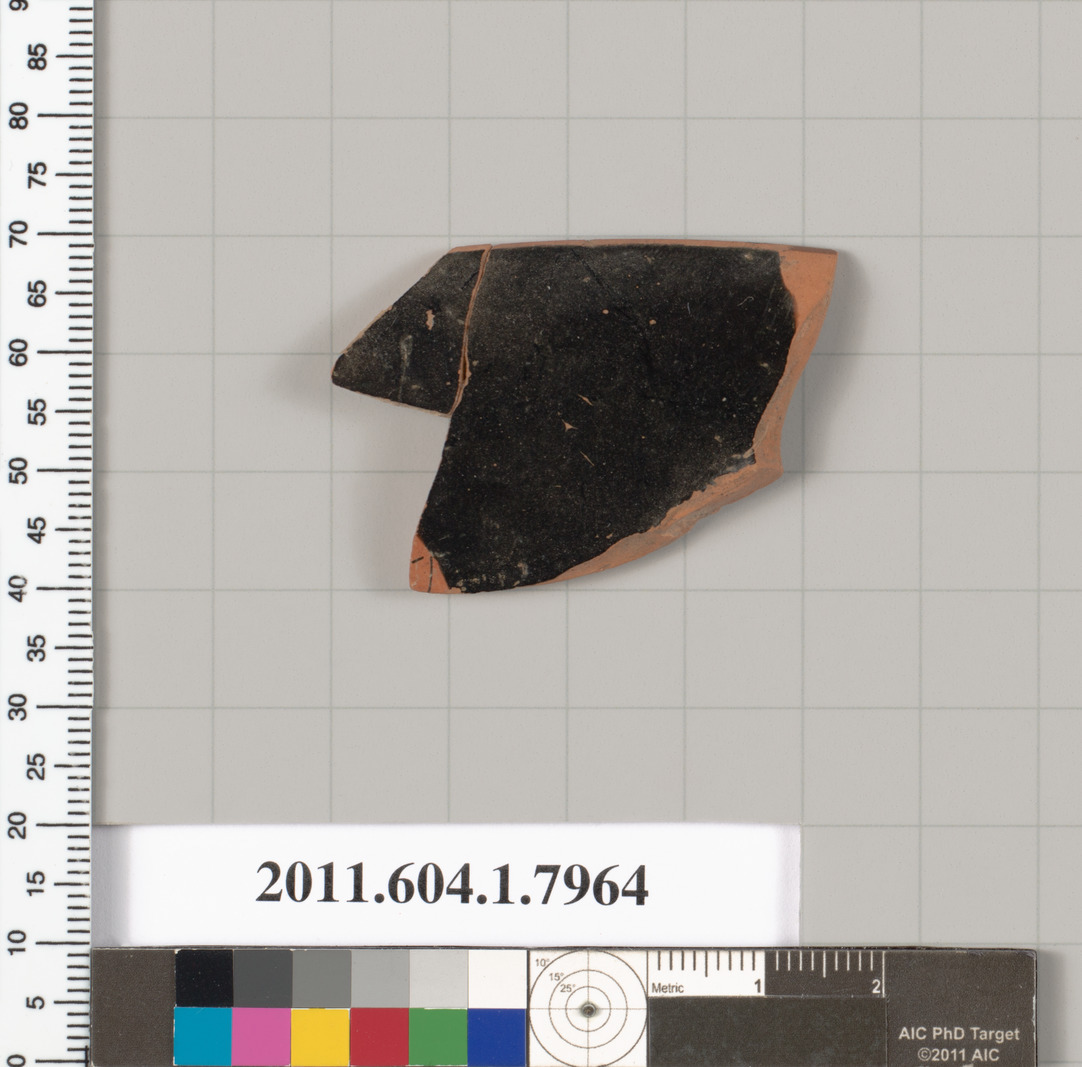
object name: kylix fragment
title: Terracotta rim fragment of a kylix (drinking cup)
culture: greek, attic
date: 460-450 BCE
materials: terracotta